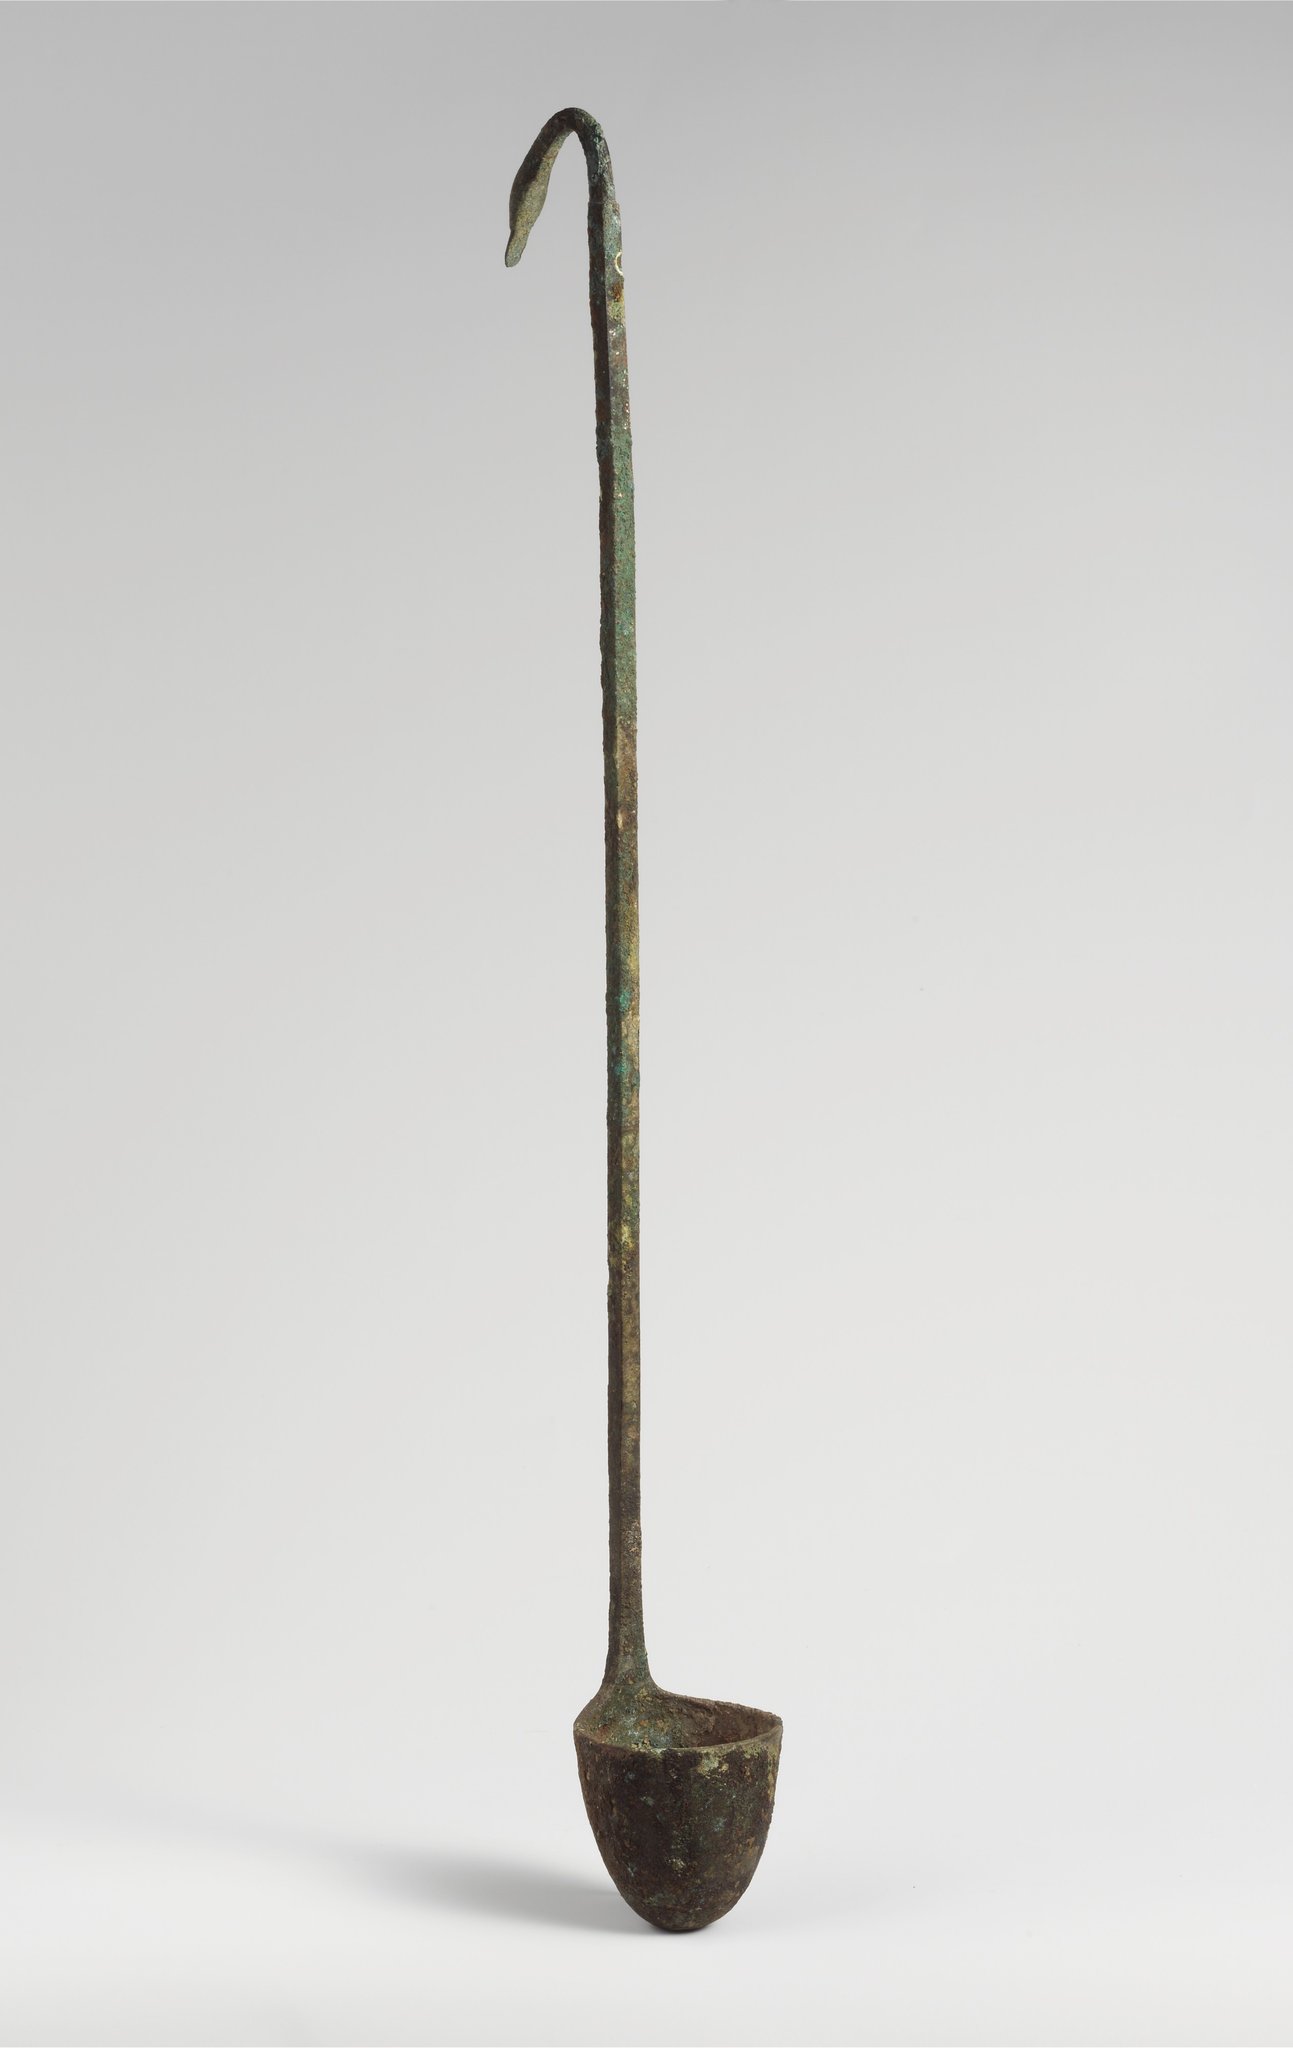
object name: ladle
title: Bronze kyathos (ladle) with duck-head terminal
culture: etruscan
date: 400 BCE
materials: bronze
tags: ducks